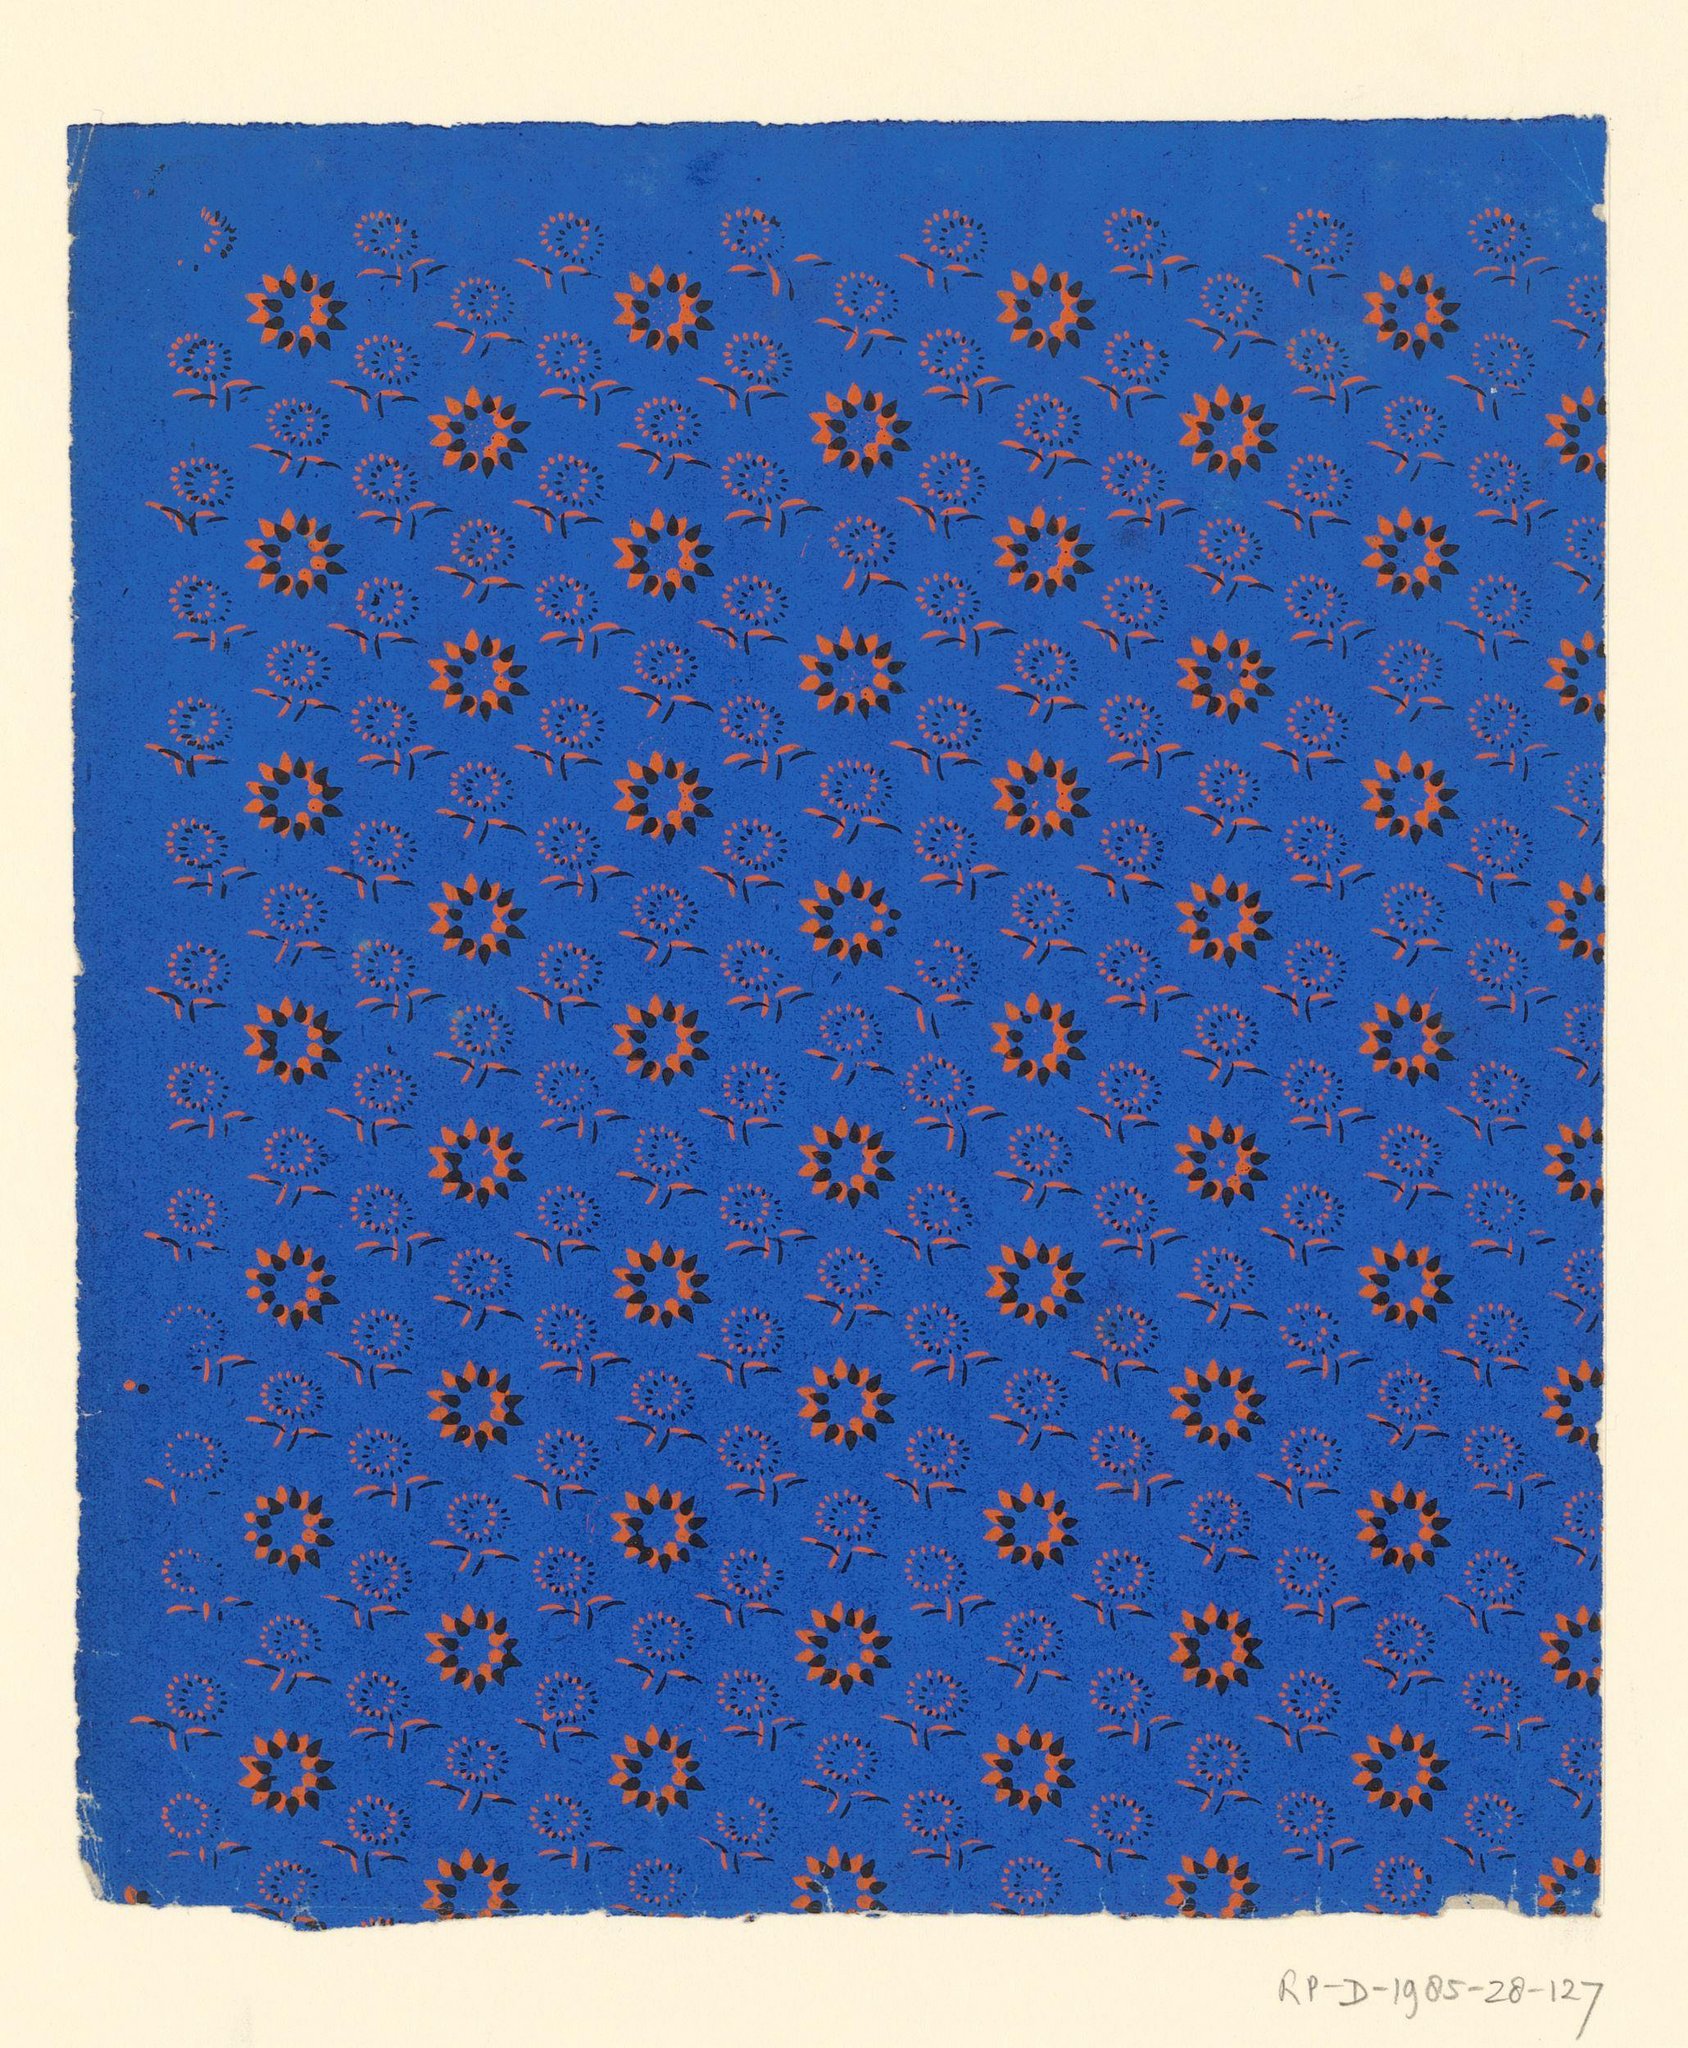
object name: printed paper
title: Blad met alternerend strooipatroon van grote en kleine bloemen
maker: Anonymous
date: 1750-1900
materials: paper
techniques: printing block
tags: ornament derived from plant forms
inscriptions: collector's mark: Lugt 2228, collector's mark: Lugt 2760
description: Blad met alternerend strooipatroon van grote en kleine bloemen. Waarschijnlijk de helft van een omslag.